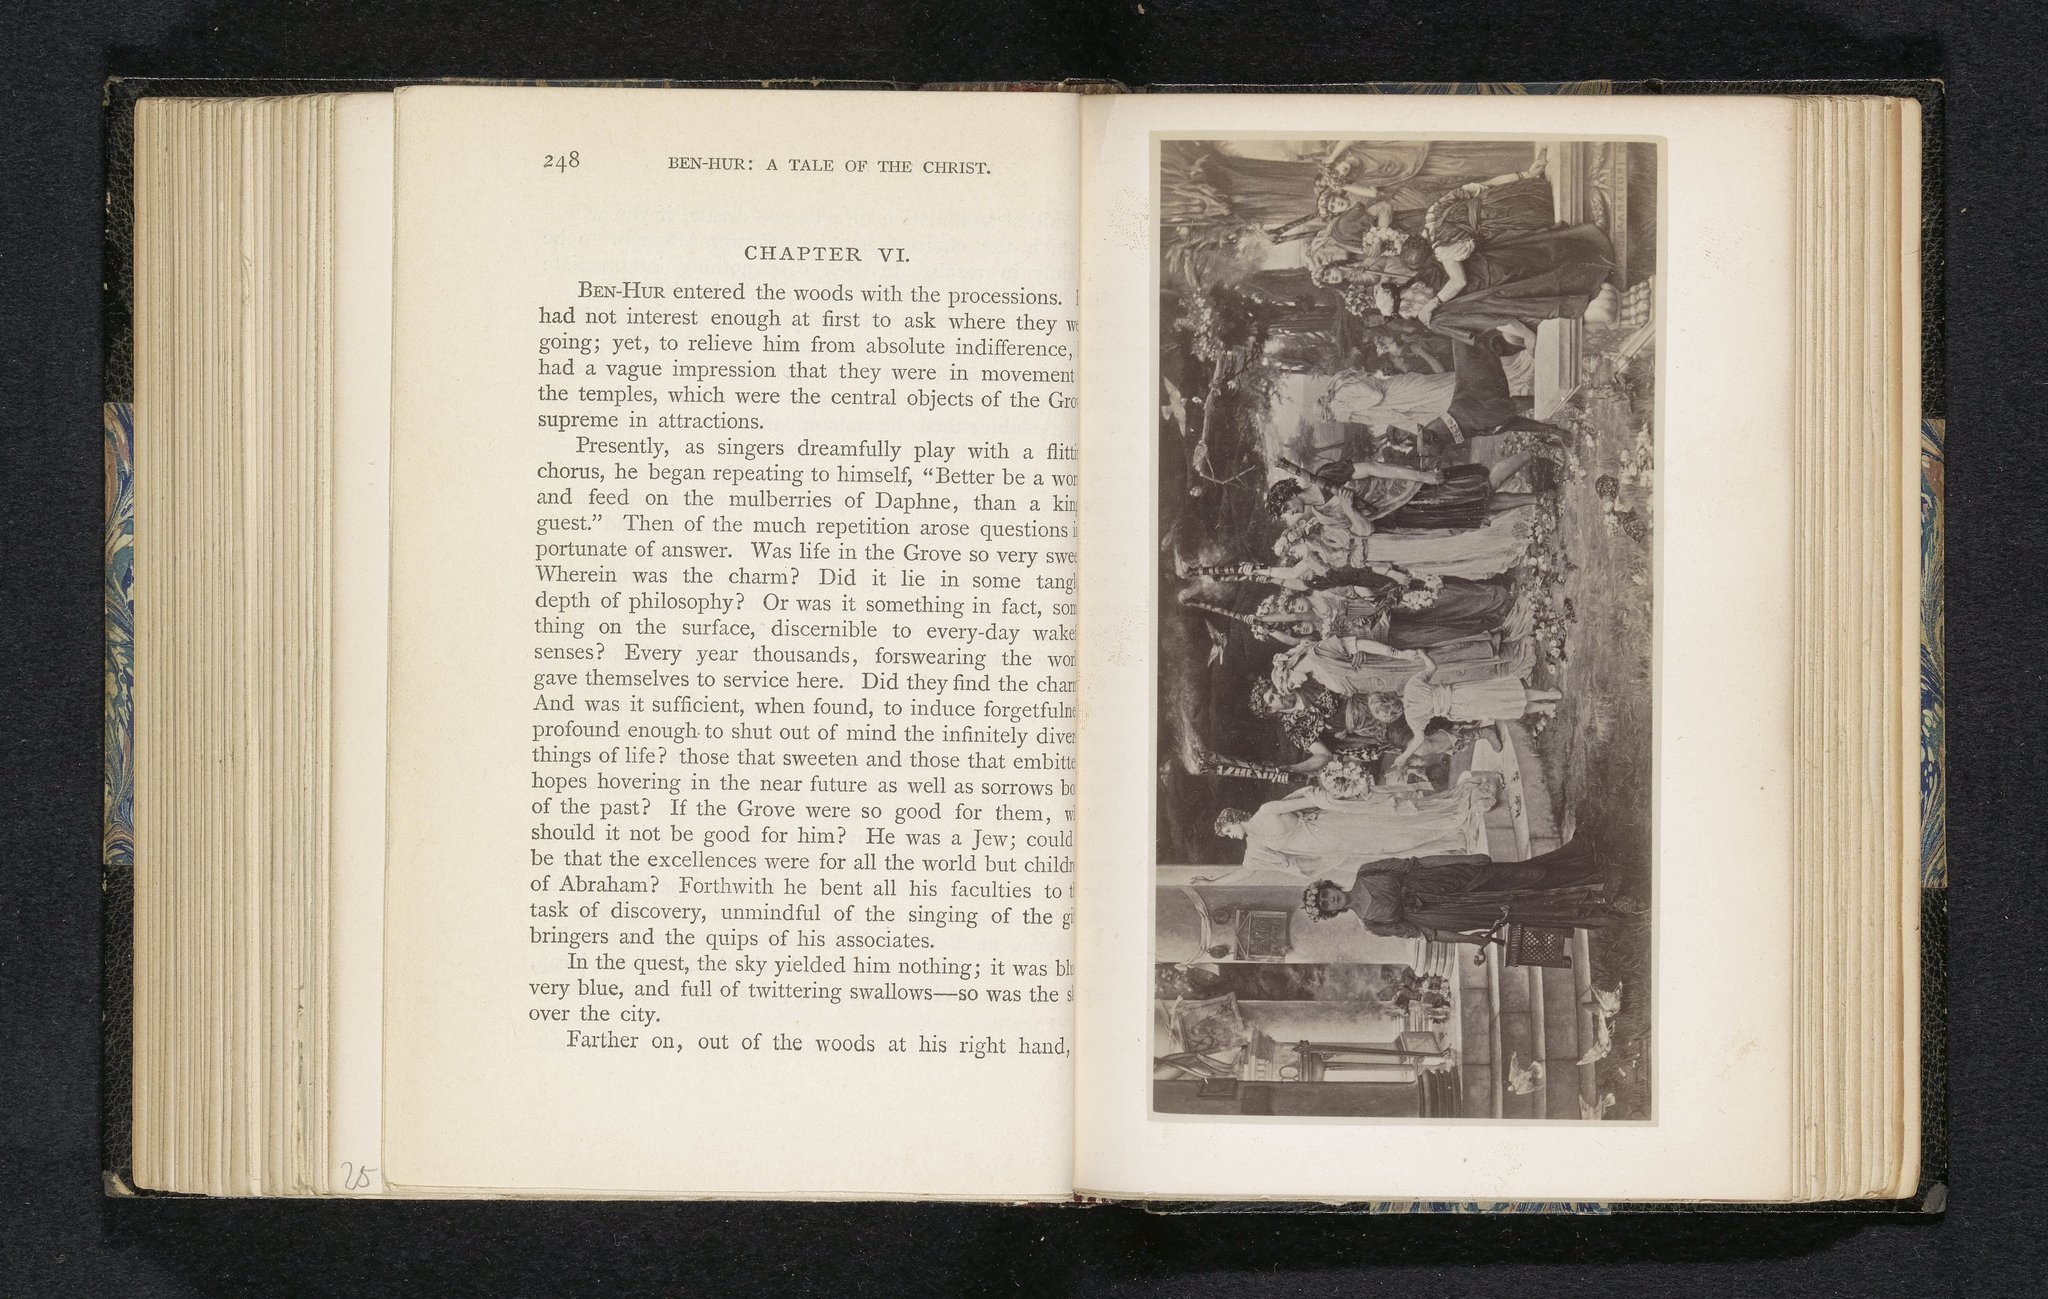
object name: page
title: Fotoreproductie van een schilderij, voorstellende een processie voor de tempel van Eros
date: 1883-1888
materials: photographic support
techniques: albumen print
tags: torch, (story of) cupid, amor (eros), procession ~ roman religion